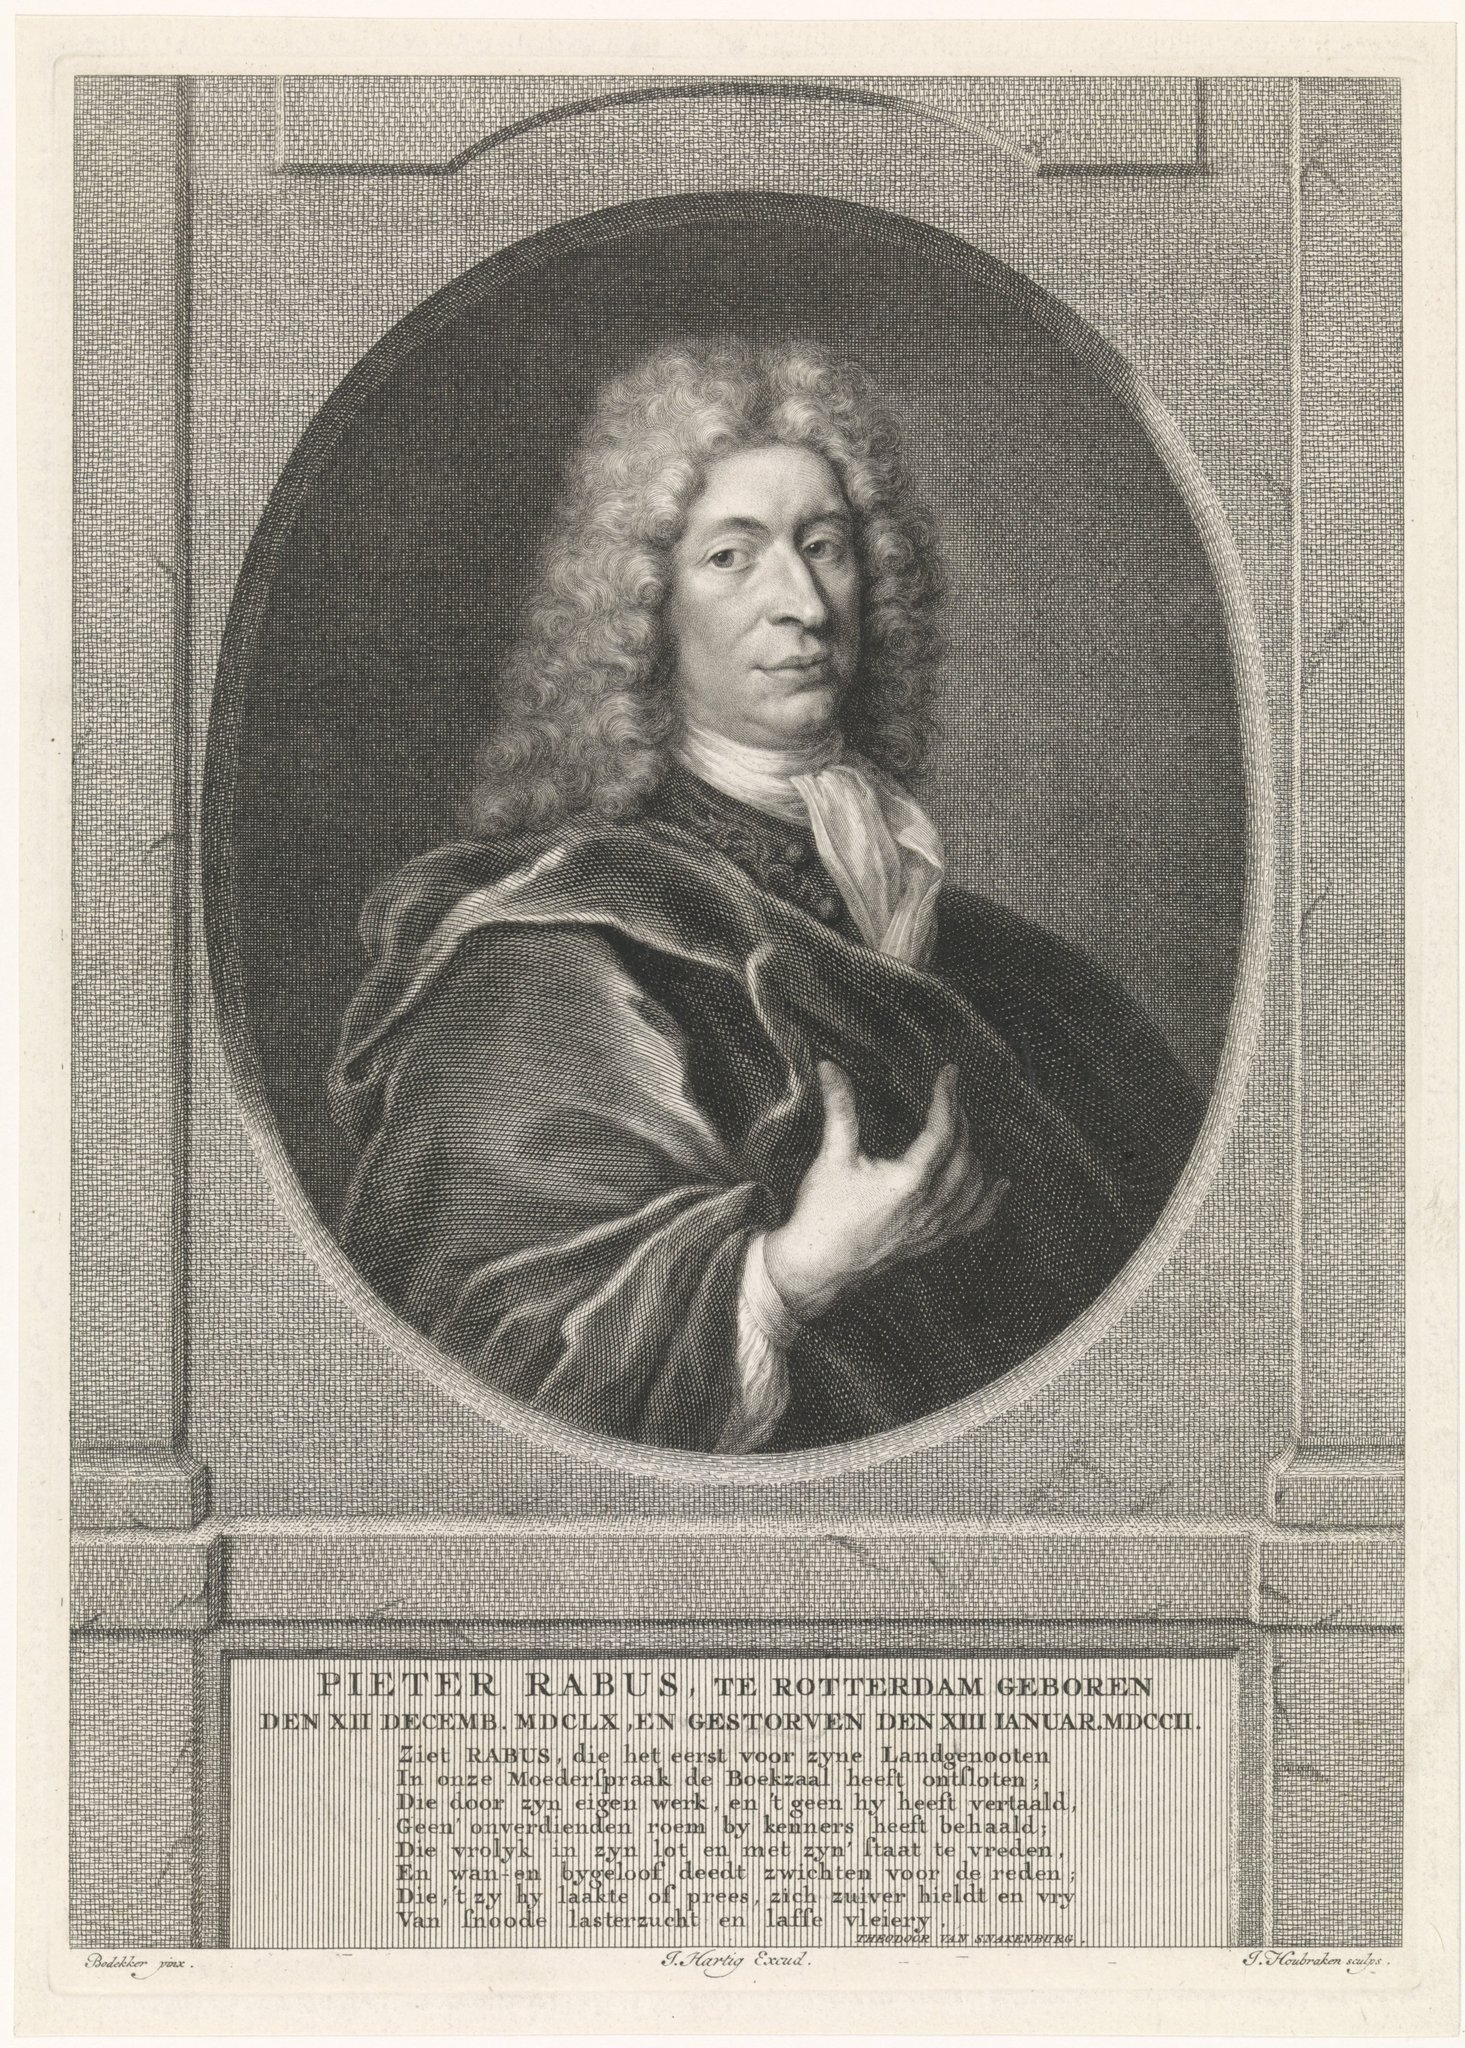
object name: print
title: Portret van Pieter Rabus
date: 1736-1759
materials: paper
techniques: engraving, etching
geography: amsterdam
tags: pieter rabus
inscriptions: collector's mark: Lugt 2228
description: Buste naar rechts van Pieter Rabus in een ovaal architectonisch venster. Onder het portret zijn naam en gegevens in twee regels in het Latijn een daaronder een achtregelig vers in het Nederlands.